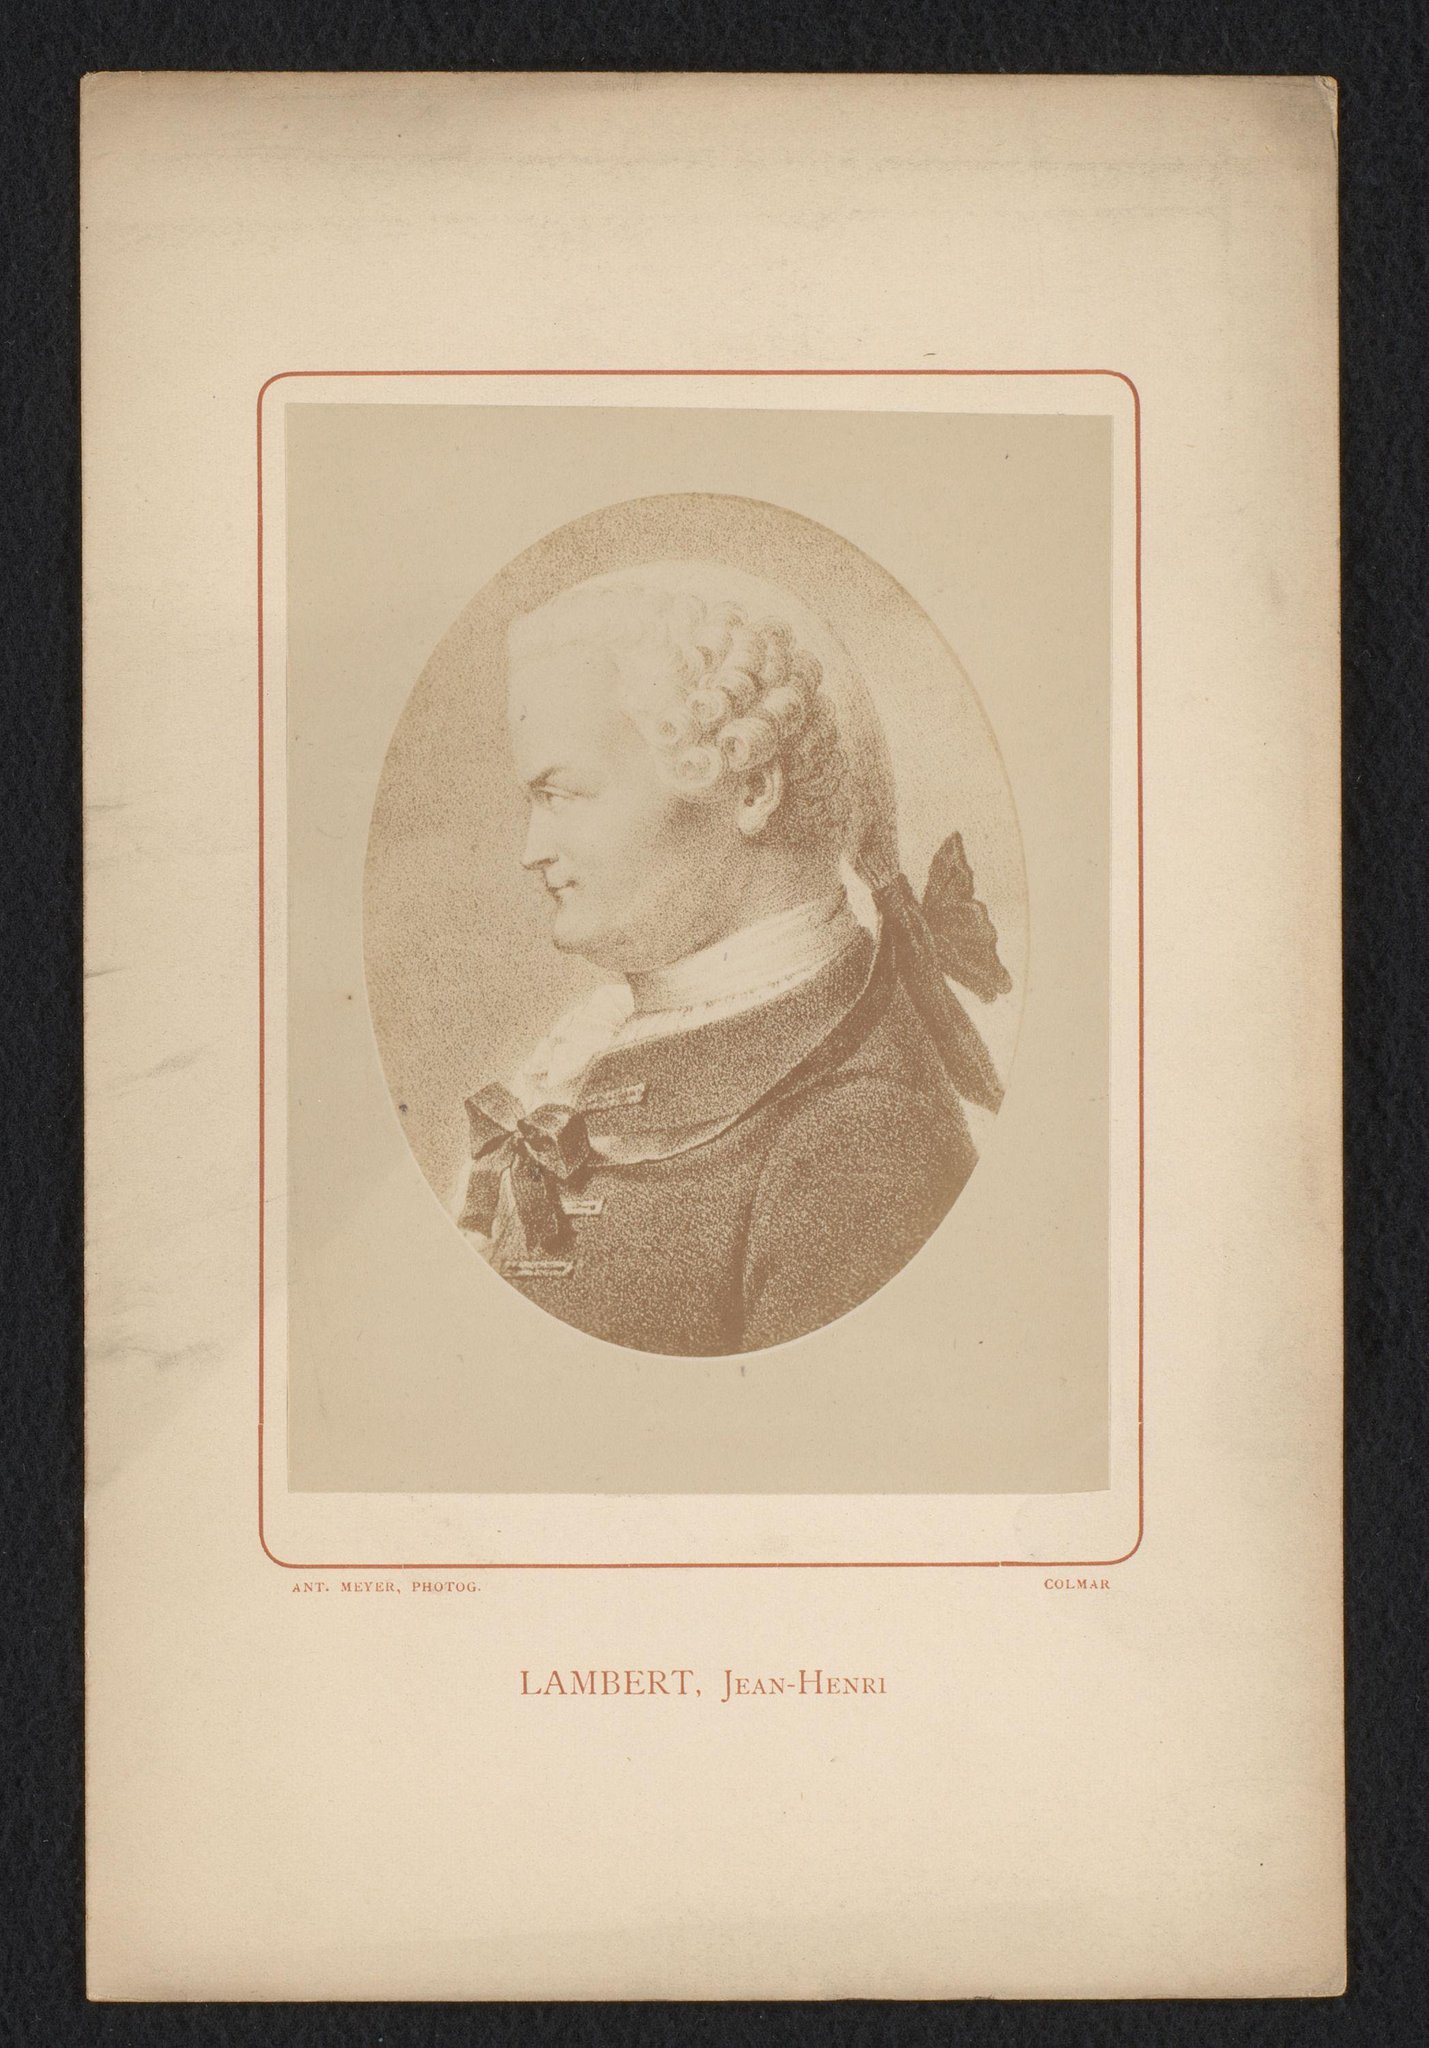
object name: photograph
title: Fotoreproductie van een prent van een portret van Jean-Henri Lambert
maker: anton meyer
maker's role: fotograaf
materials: photographic support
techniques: albumen print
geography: colmar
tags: berlin, physicist, johann heinrich lambert, historical persons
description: Deze foto maakt deel uit van een omslag met 29 foto's op 29 bladen en 23 teksbladen.